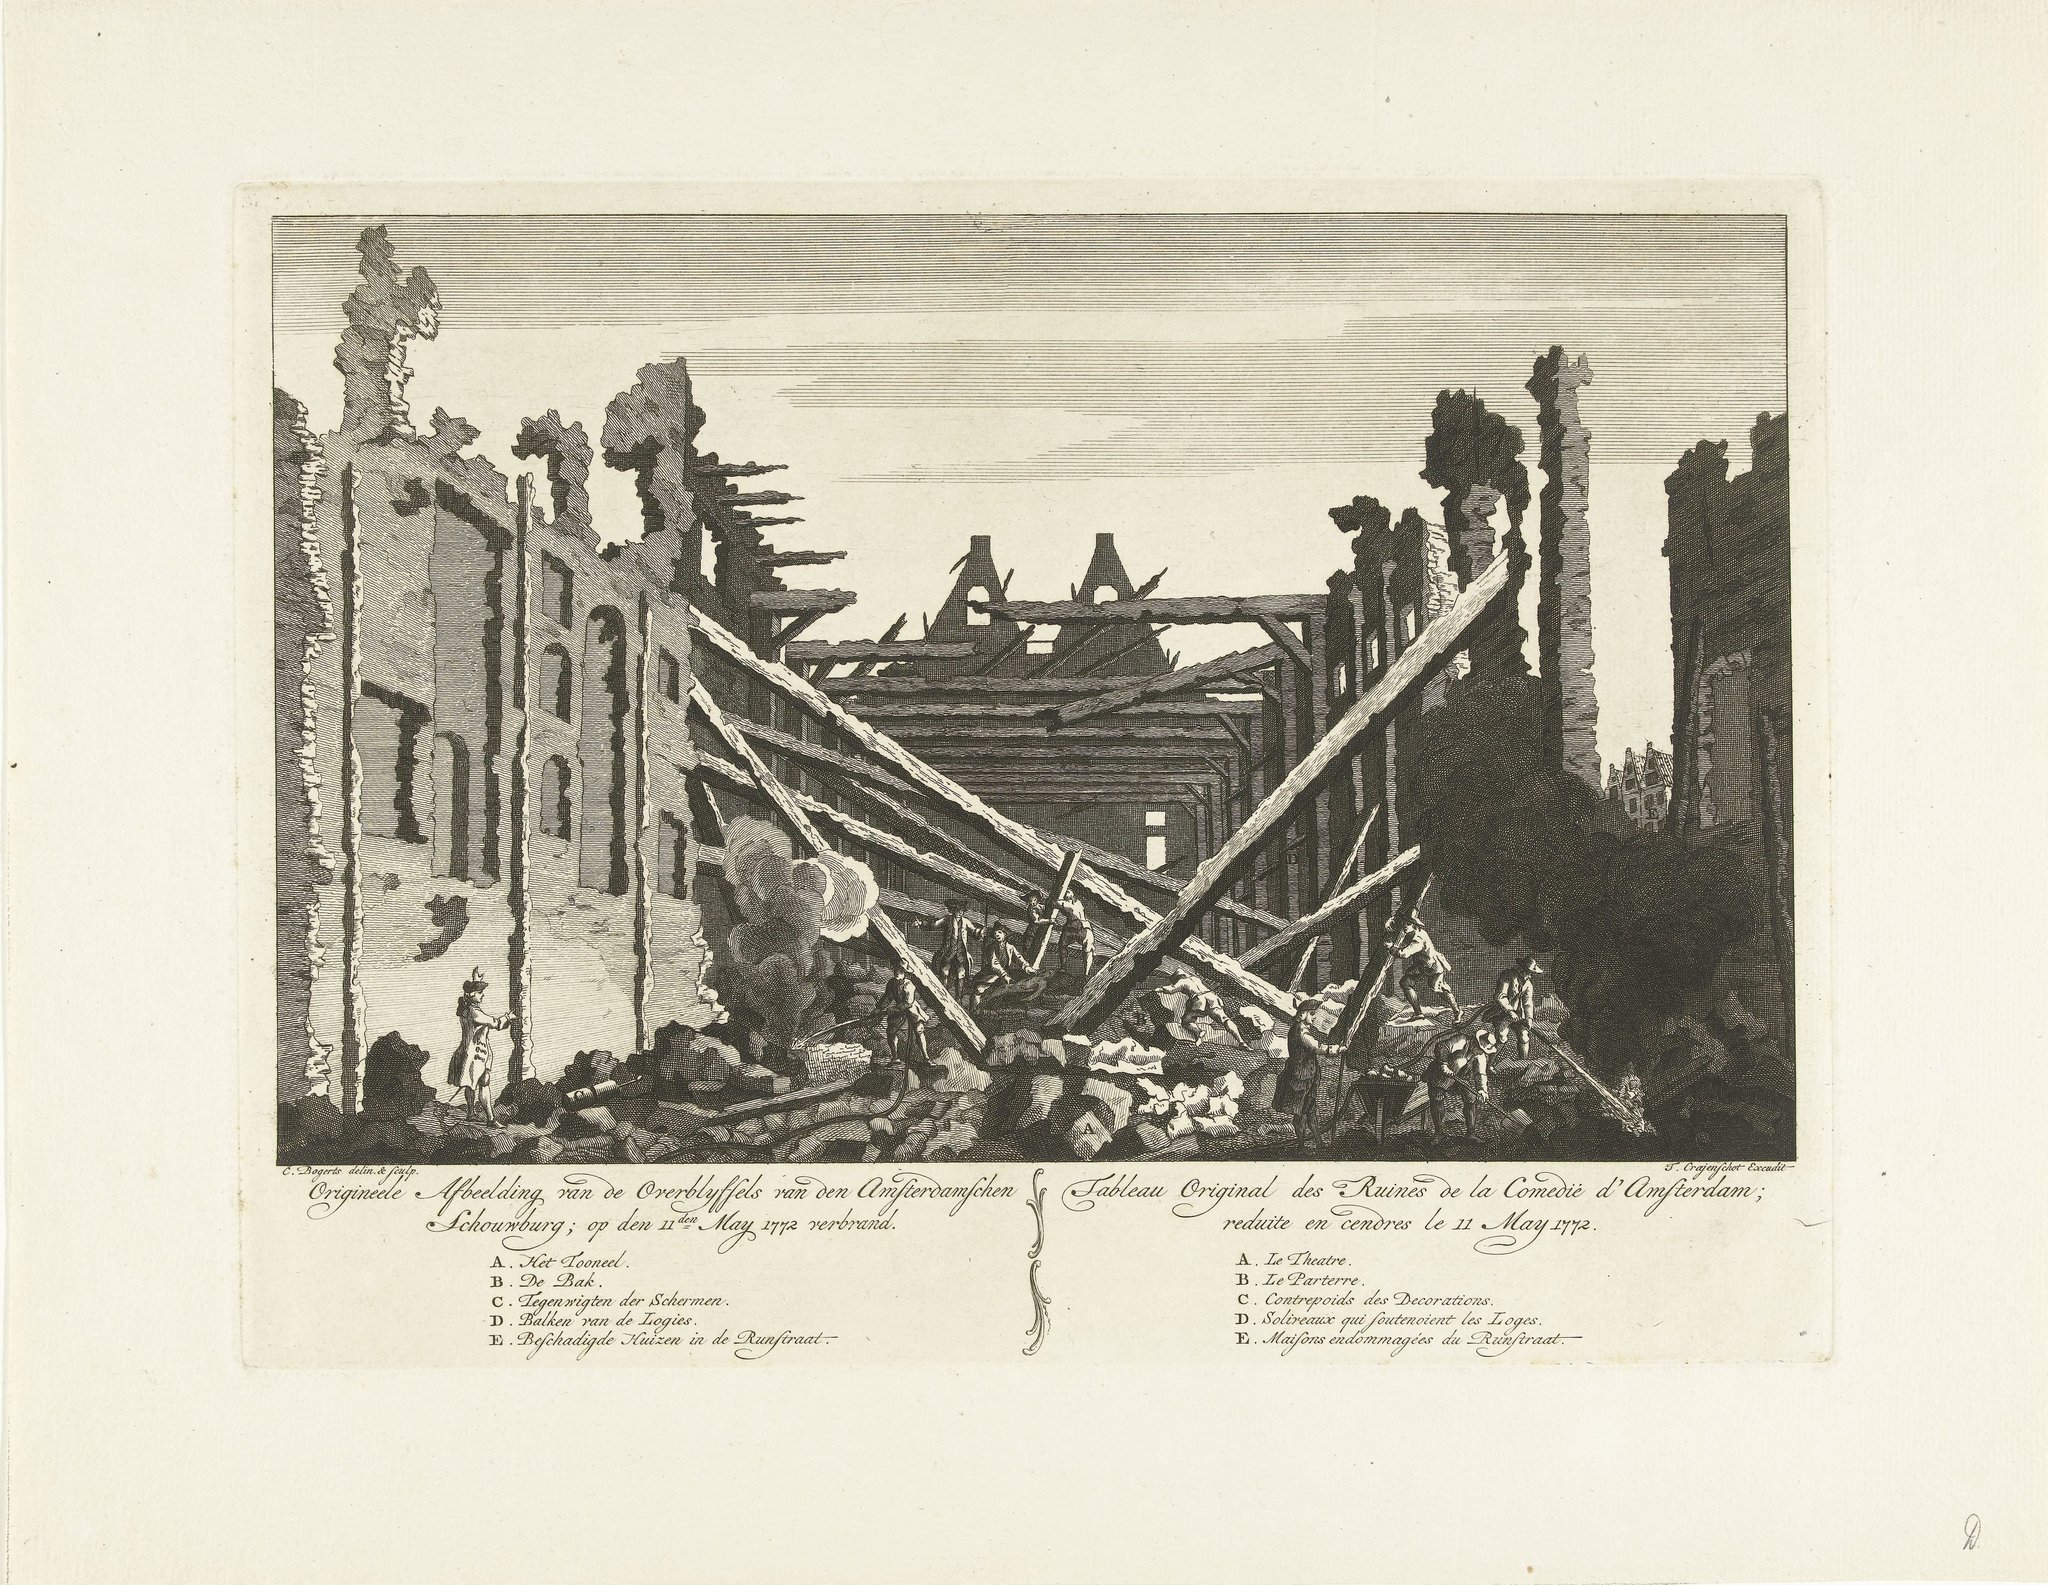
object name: print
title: Ruïne van de afgebrande schouwburg aan de Keizersgracht te Amsterdam, 1772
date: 1772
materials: paper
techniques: engraving, etching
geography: amsterdam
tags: on fire, ablaze, theatre, theatrical performance, ruin of a building ~ architecture, theatre (building), fire-fighting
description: Gezicht op de ruïne van de Amsterdamse Schouwburg aan de Keizersgracht na de brand van 11 mei 1772. Brandweerlieden blussen met waterspuiten de laatste vuurhaarden, anderen ruimen puin. Onder de voorstelling de titel en legenda A-E in het Nederlands (links) en Frans (rechts). Onderdeel van een serie van vier prenten met titelprent over de brand in de Amsterdamse Schouwburg.